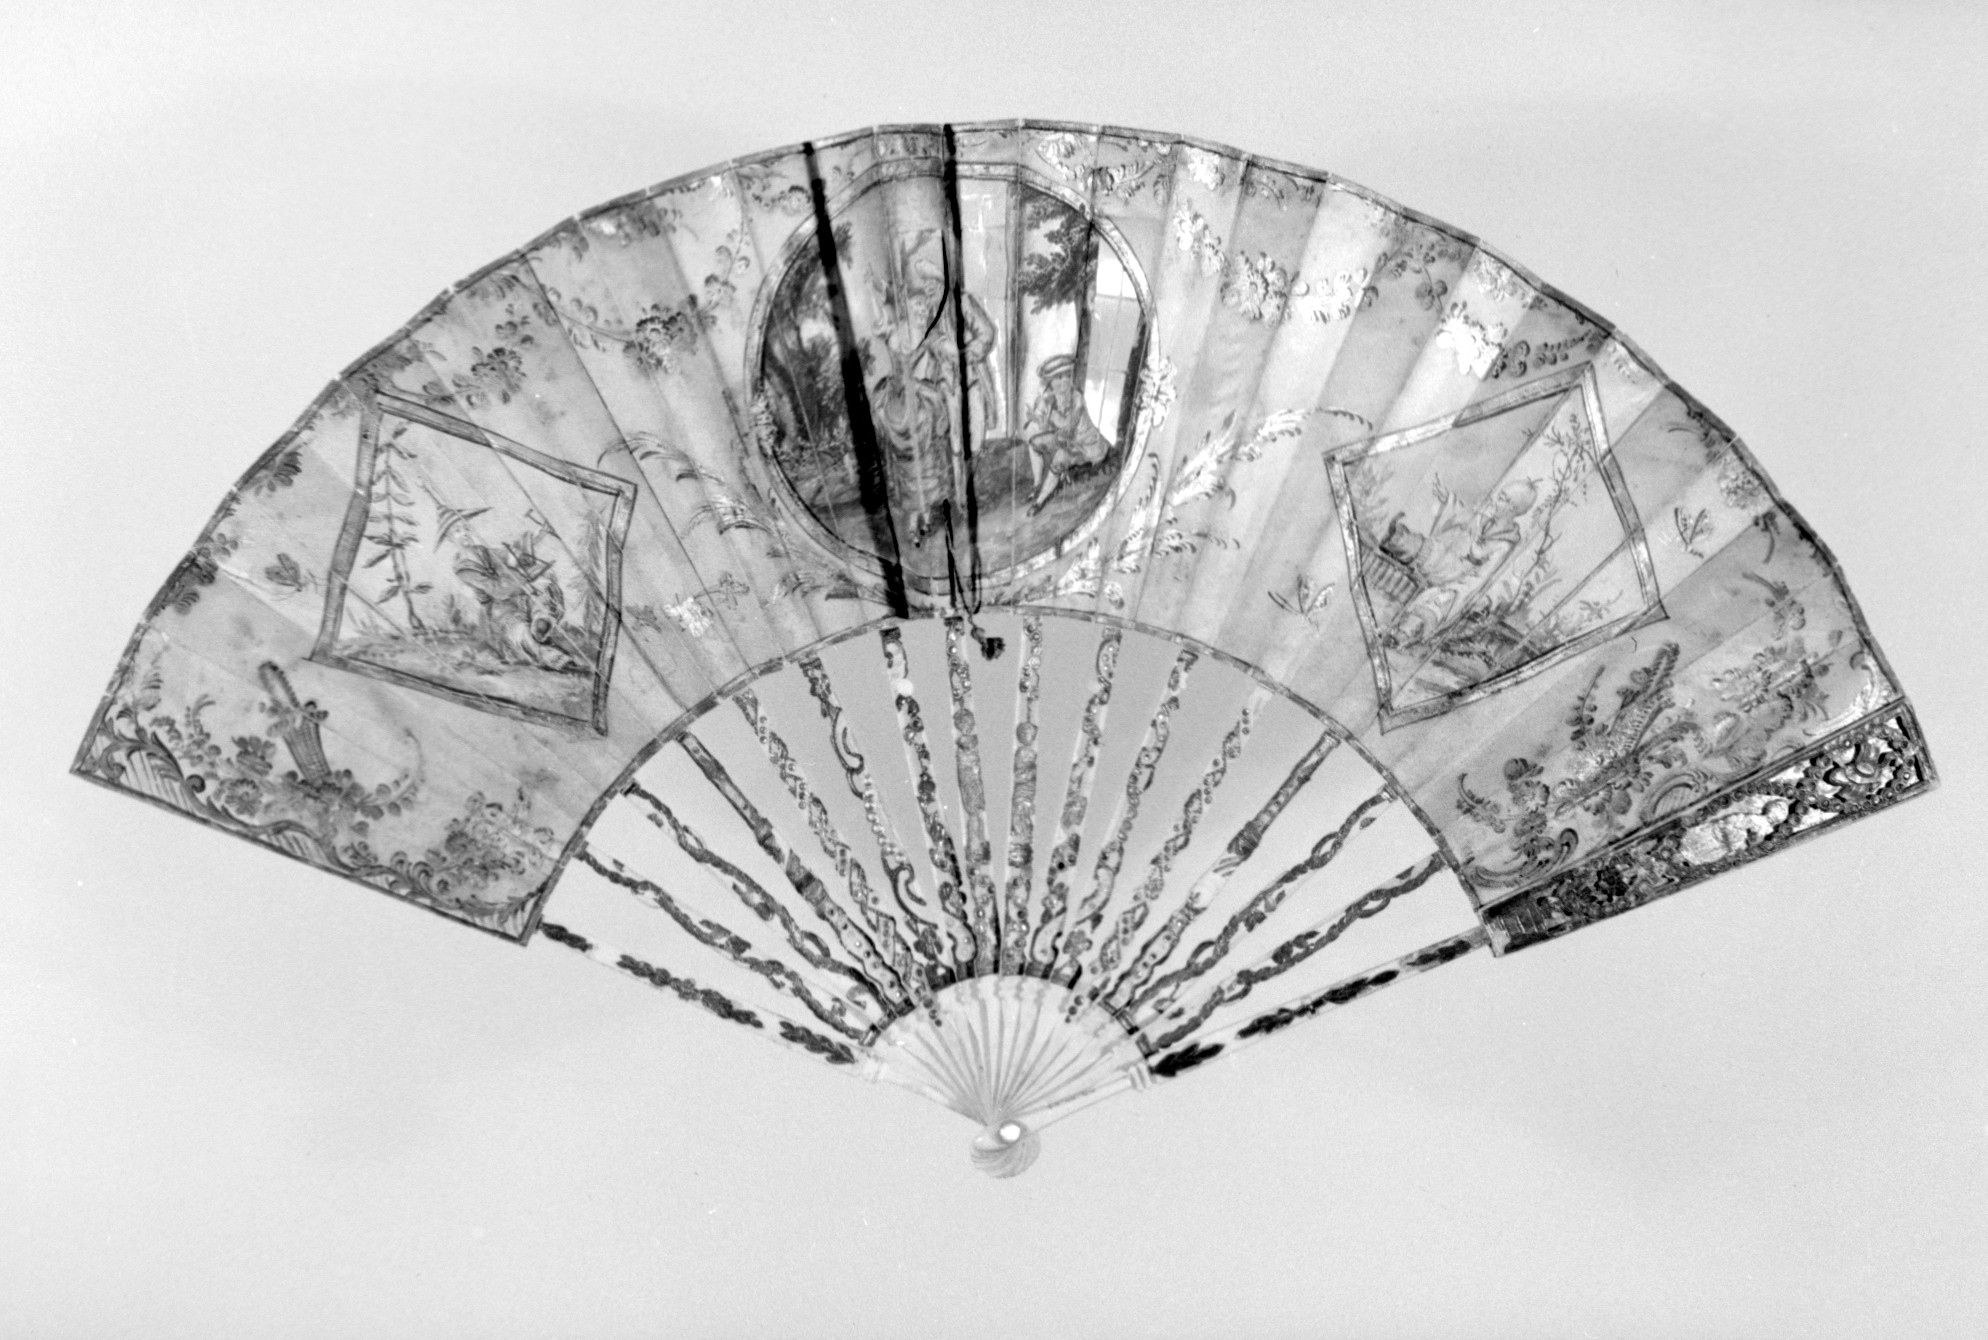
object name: fan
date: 1701-1800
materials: gold foil, ivory, metal, mica, mother of pearl, paper, parchment, silk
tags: men,women